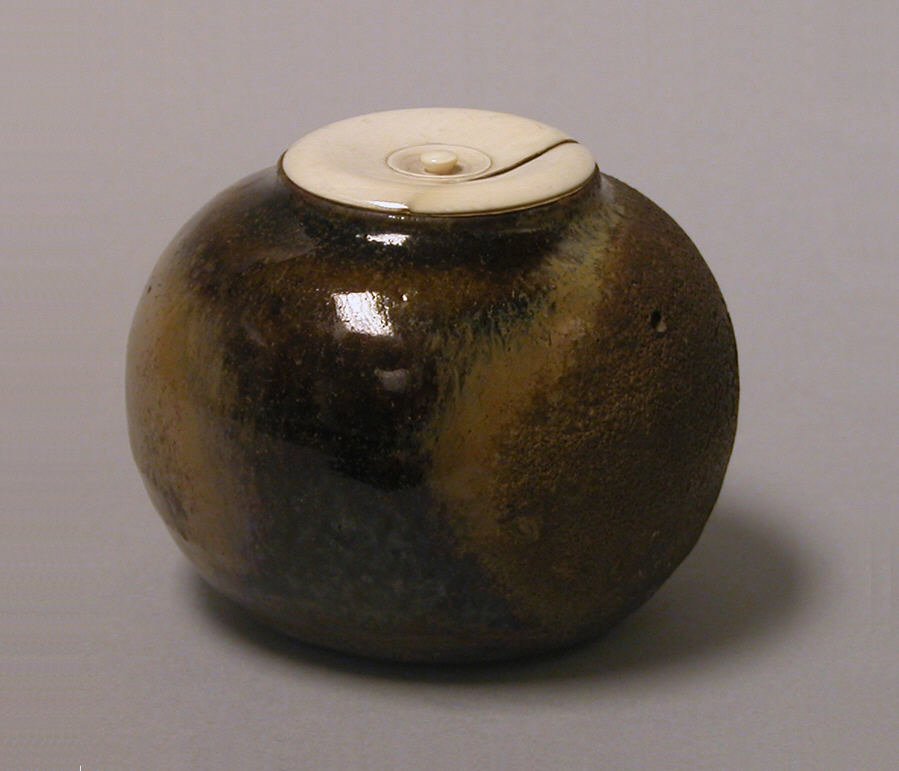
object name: tea caddy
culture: japanese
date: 1701-1800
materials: clay, glaze